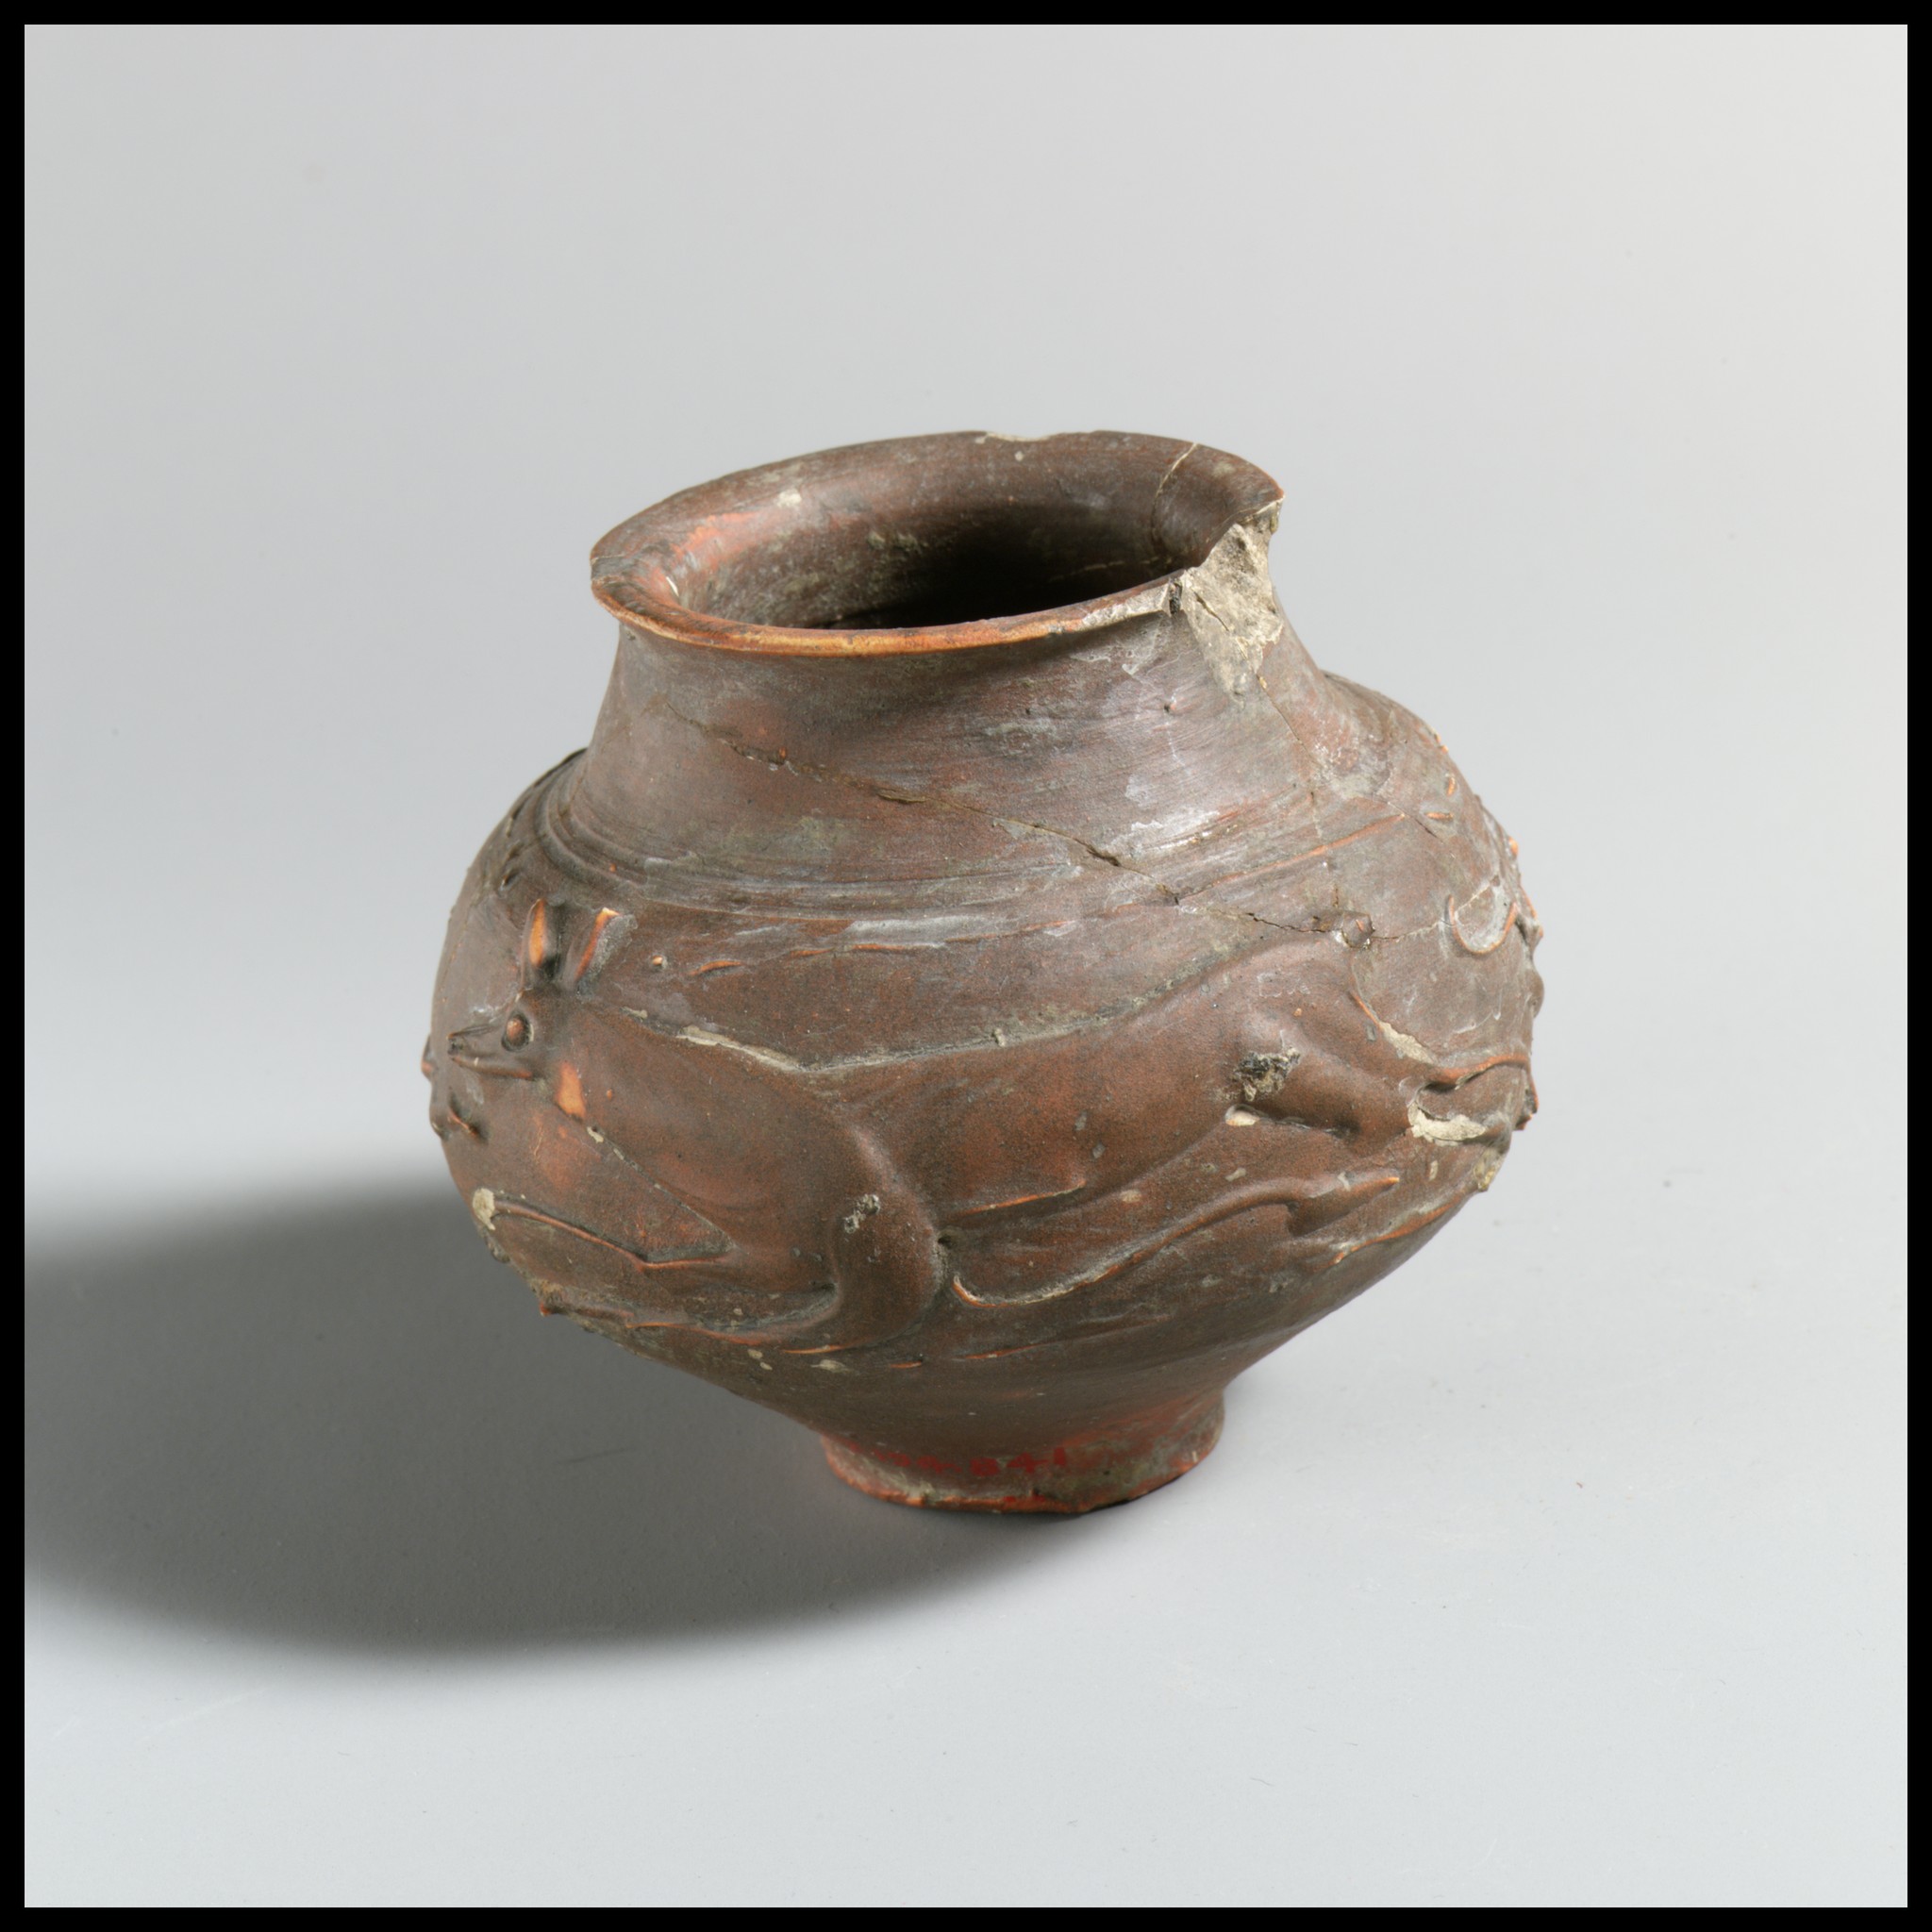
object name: vase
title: Terracotta beaker with barbotine decoration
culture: roman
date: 167-233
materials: terracotta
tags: dogs,leaves